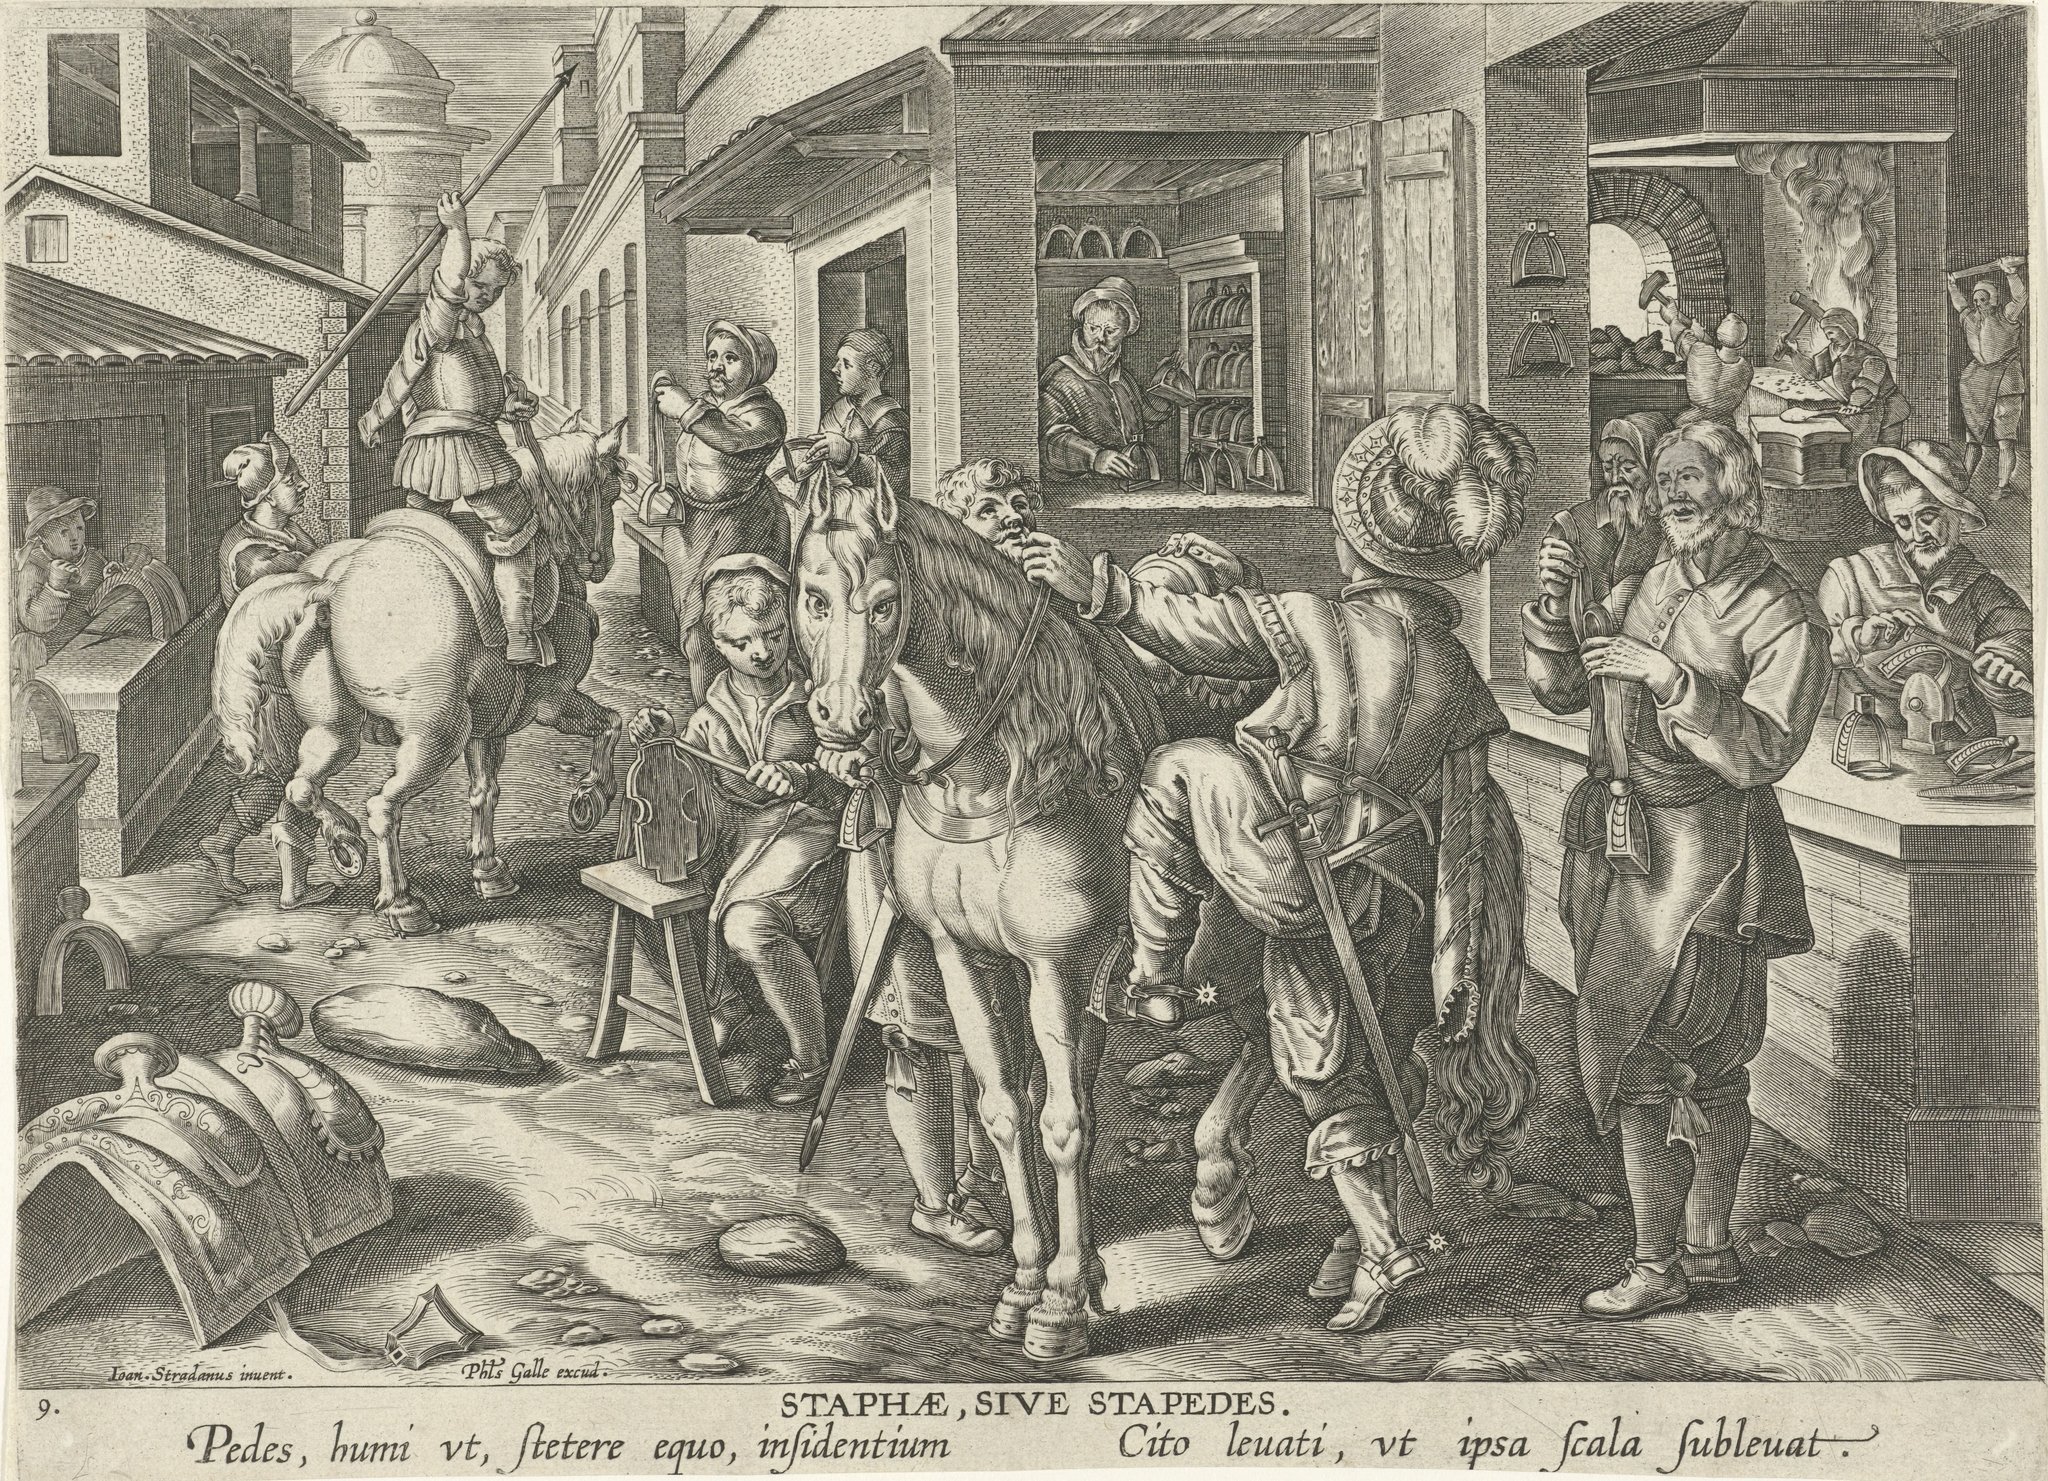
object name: print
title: Nieuwe uitvindingen en ontdekkingen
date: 1589-1593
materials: paper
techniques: engraving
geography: antwerp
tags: shop, store, riding a horse, ass, or mule; rider, horseman, saddle and bridle (saddlery), stirrup, invention, discovery ~ science and technology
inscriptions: collector's mark: Lugt 2228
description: Een straat waar paardentuig wordt gemaakt en verkocht. Op de voorgrond bestijgt een edelman zijn paard met behulp van de nieuwe stijgbeugels die hij in een winkel heeft gekocht. De prent heeft een Latijns onderschrift en maakt deel uit van een negentiendelige serie over nieuwe uitvindingen en ontdekkingen.